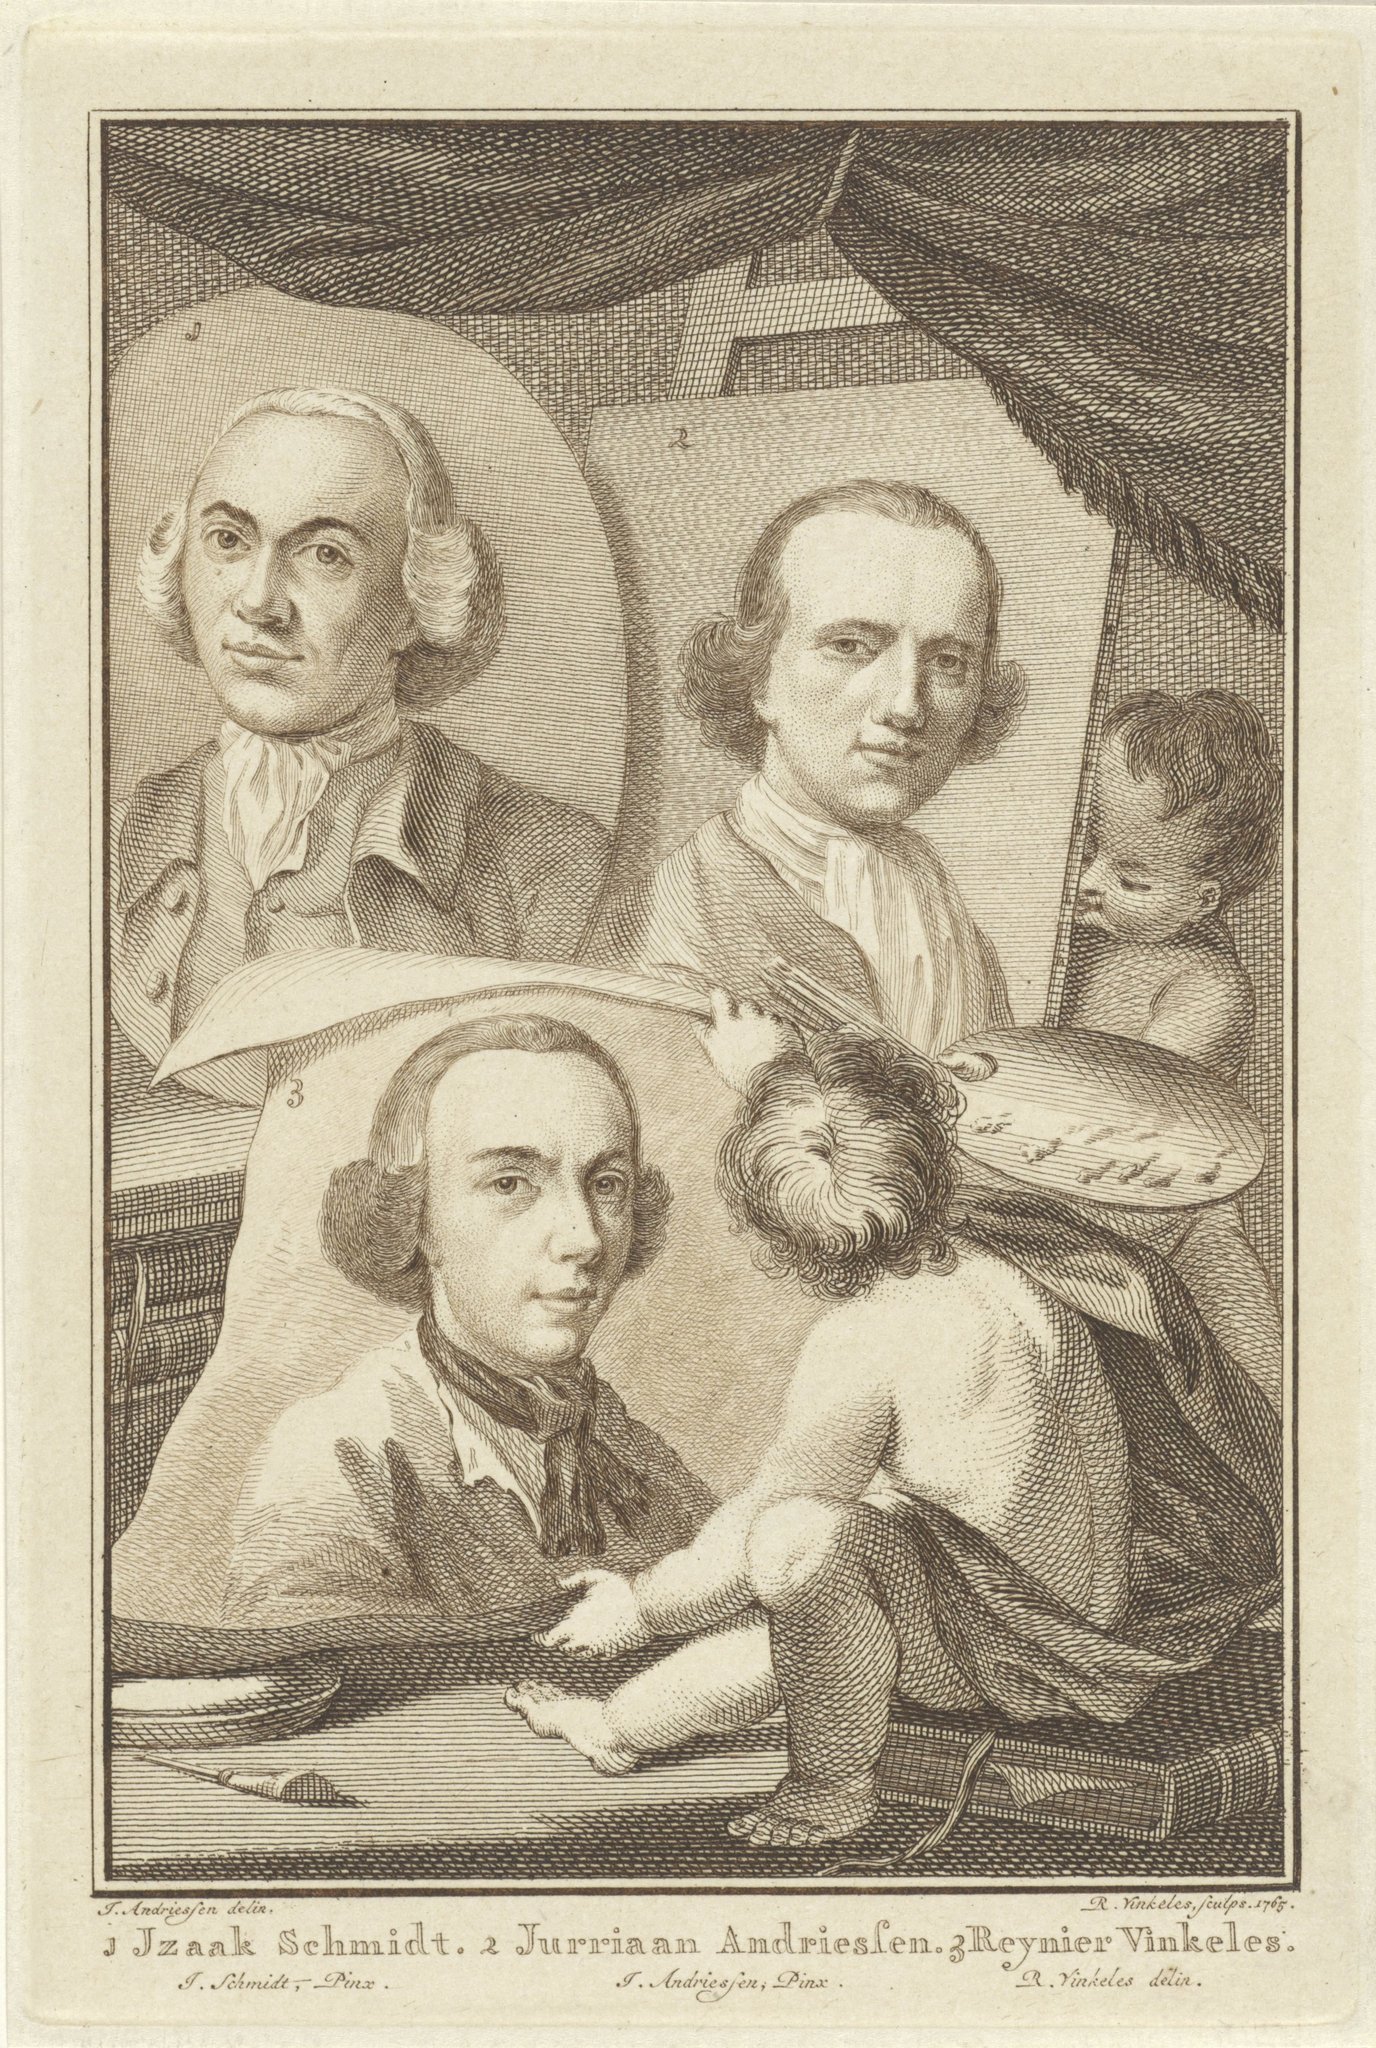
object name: print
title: Portretten van Izaak Schmidt, Jurriaan Andriessen en Reinier Vinkeles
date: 1765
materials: paper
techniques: engraving, etching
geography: amsterdam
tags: painter, jurriaan andriessen, izaak schmidt, amsterdam, print maker, draughtsman, reinier vinkeles (i), palette, cupids: 'amores', 'amoretti', 'putti'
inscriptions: collector's mark: Lugt 240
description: Twee putti bij de portretten van de kunstenaars Izaak Schmidt, Jurriaan Andriessen en Reinier Vinkeles.